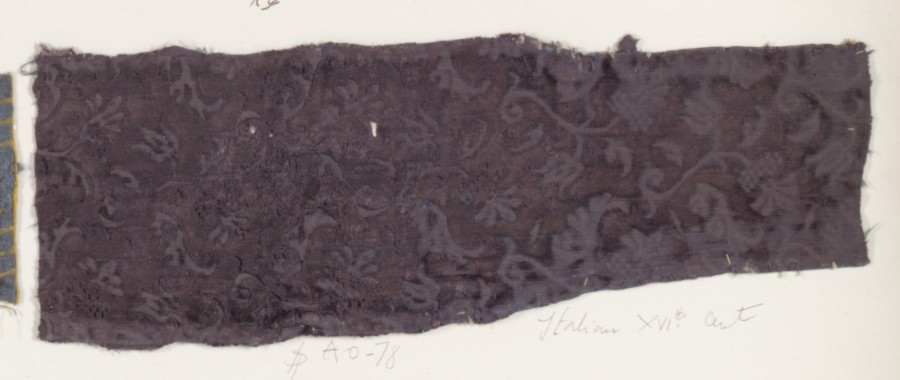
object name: fragment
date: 1501-1600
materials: silk